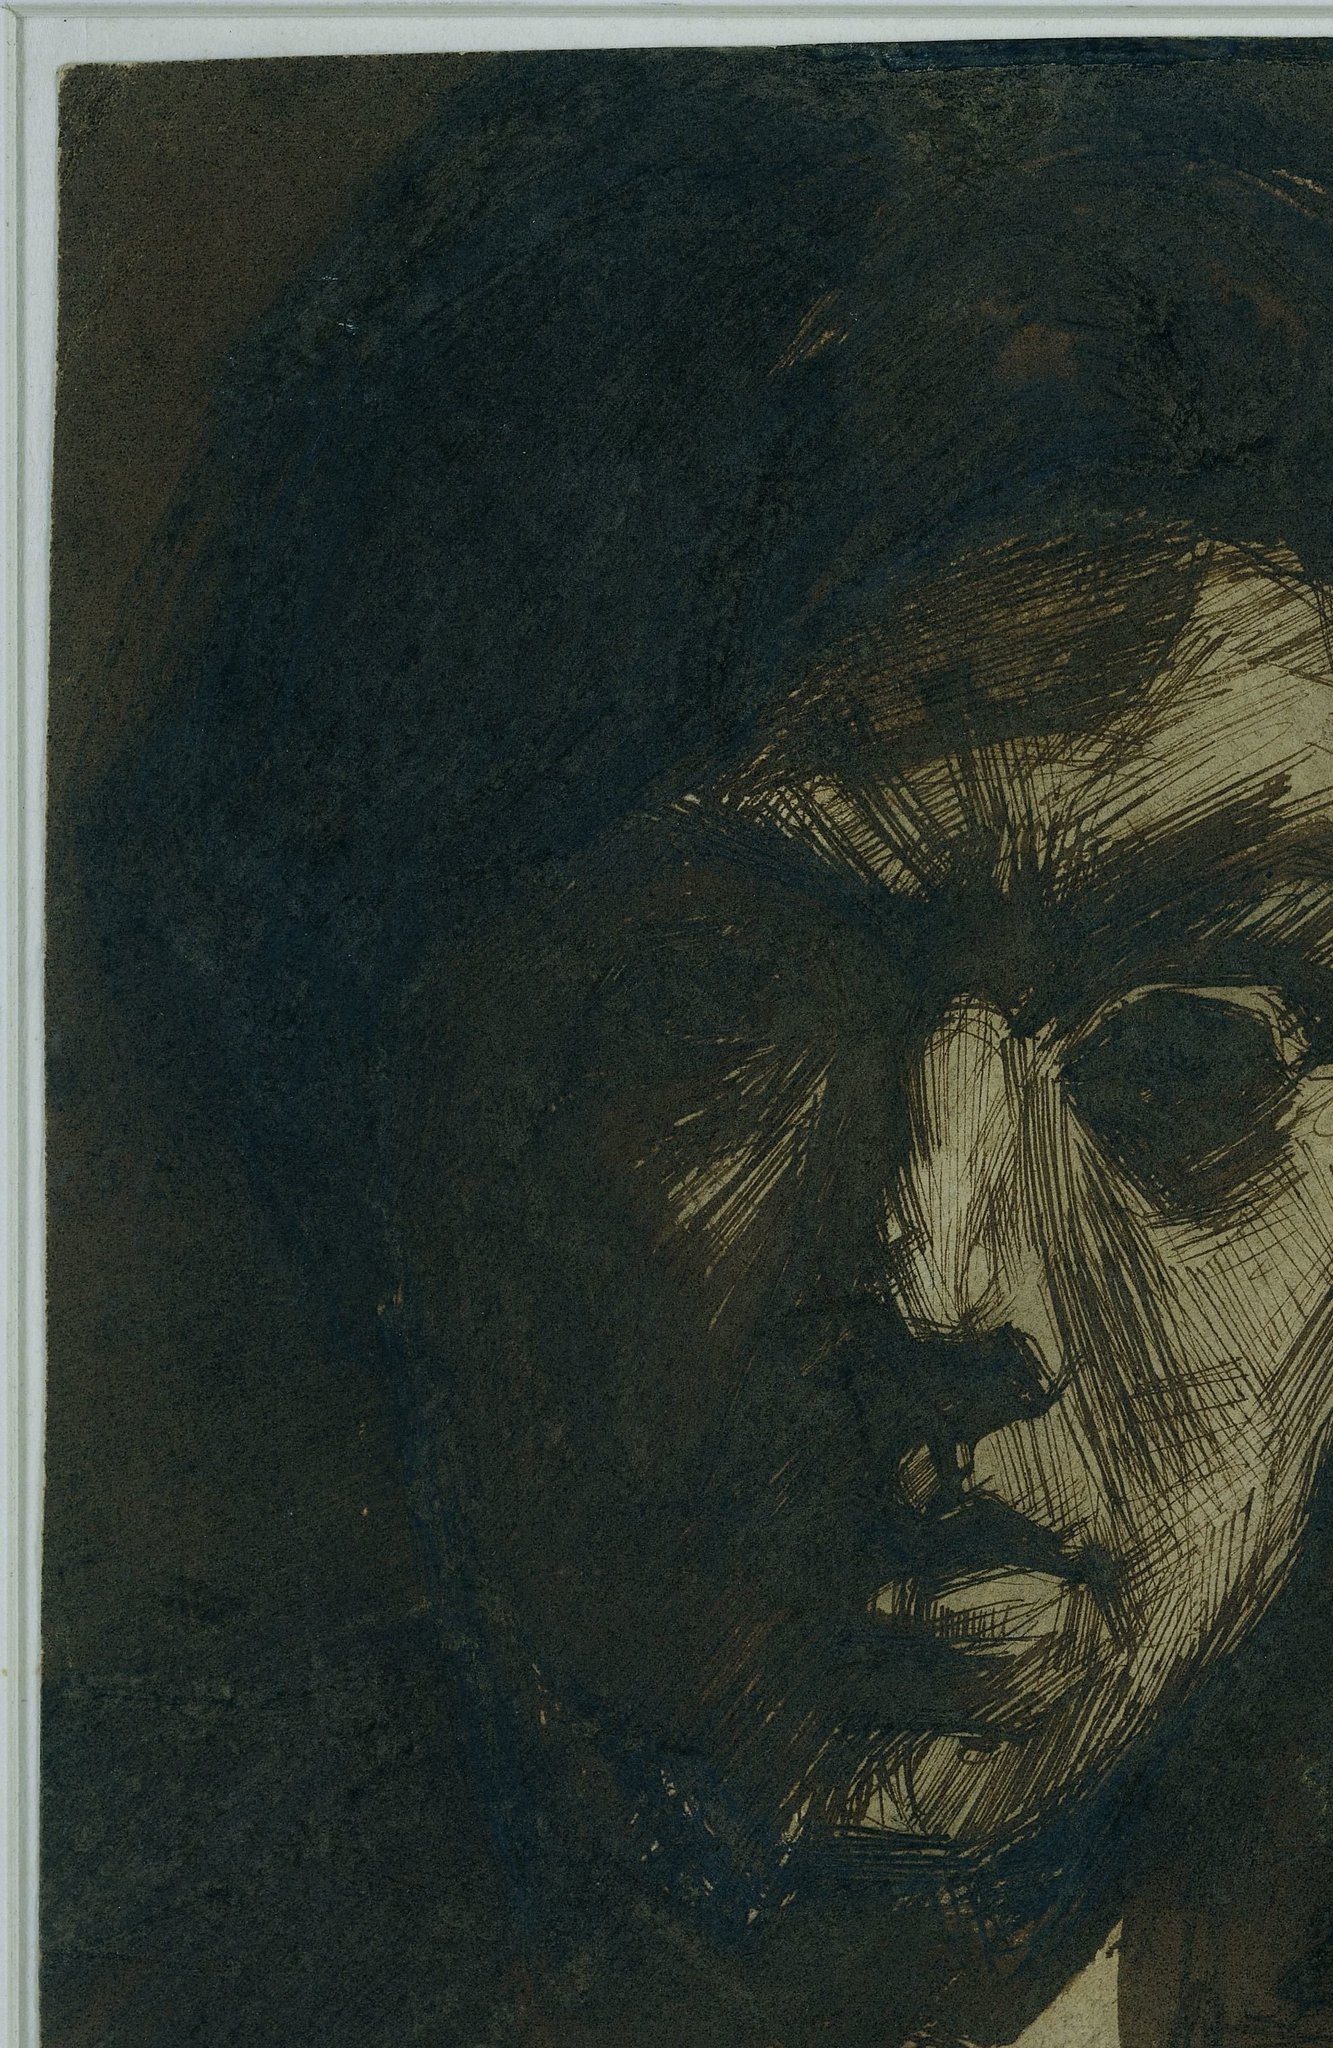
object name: drawing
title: Zelfportret van de schilder Jan Toorop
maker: jan toorop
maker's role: draughtsman, painter, print maker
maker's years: 1858-1928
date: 1880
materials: ink, paper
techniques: brush, pen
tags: the hague, painter, print maker, draughtsman, jan toorop, historical persons, portrait, self-portrait of painter, portrait, self-portrait of artist